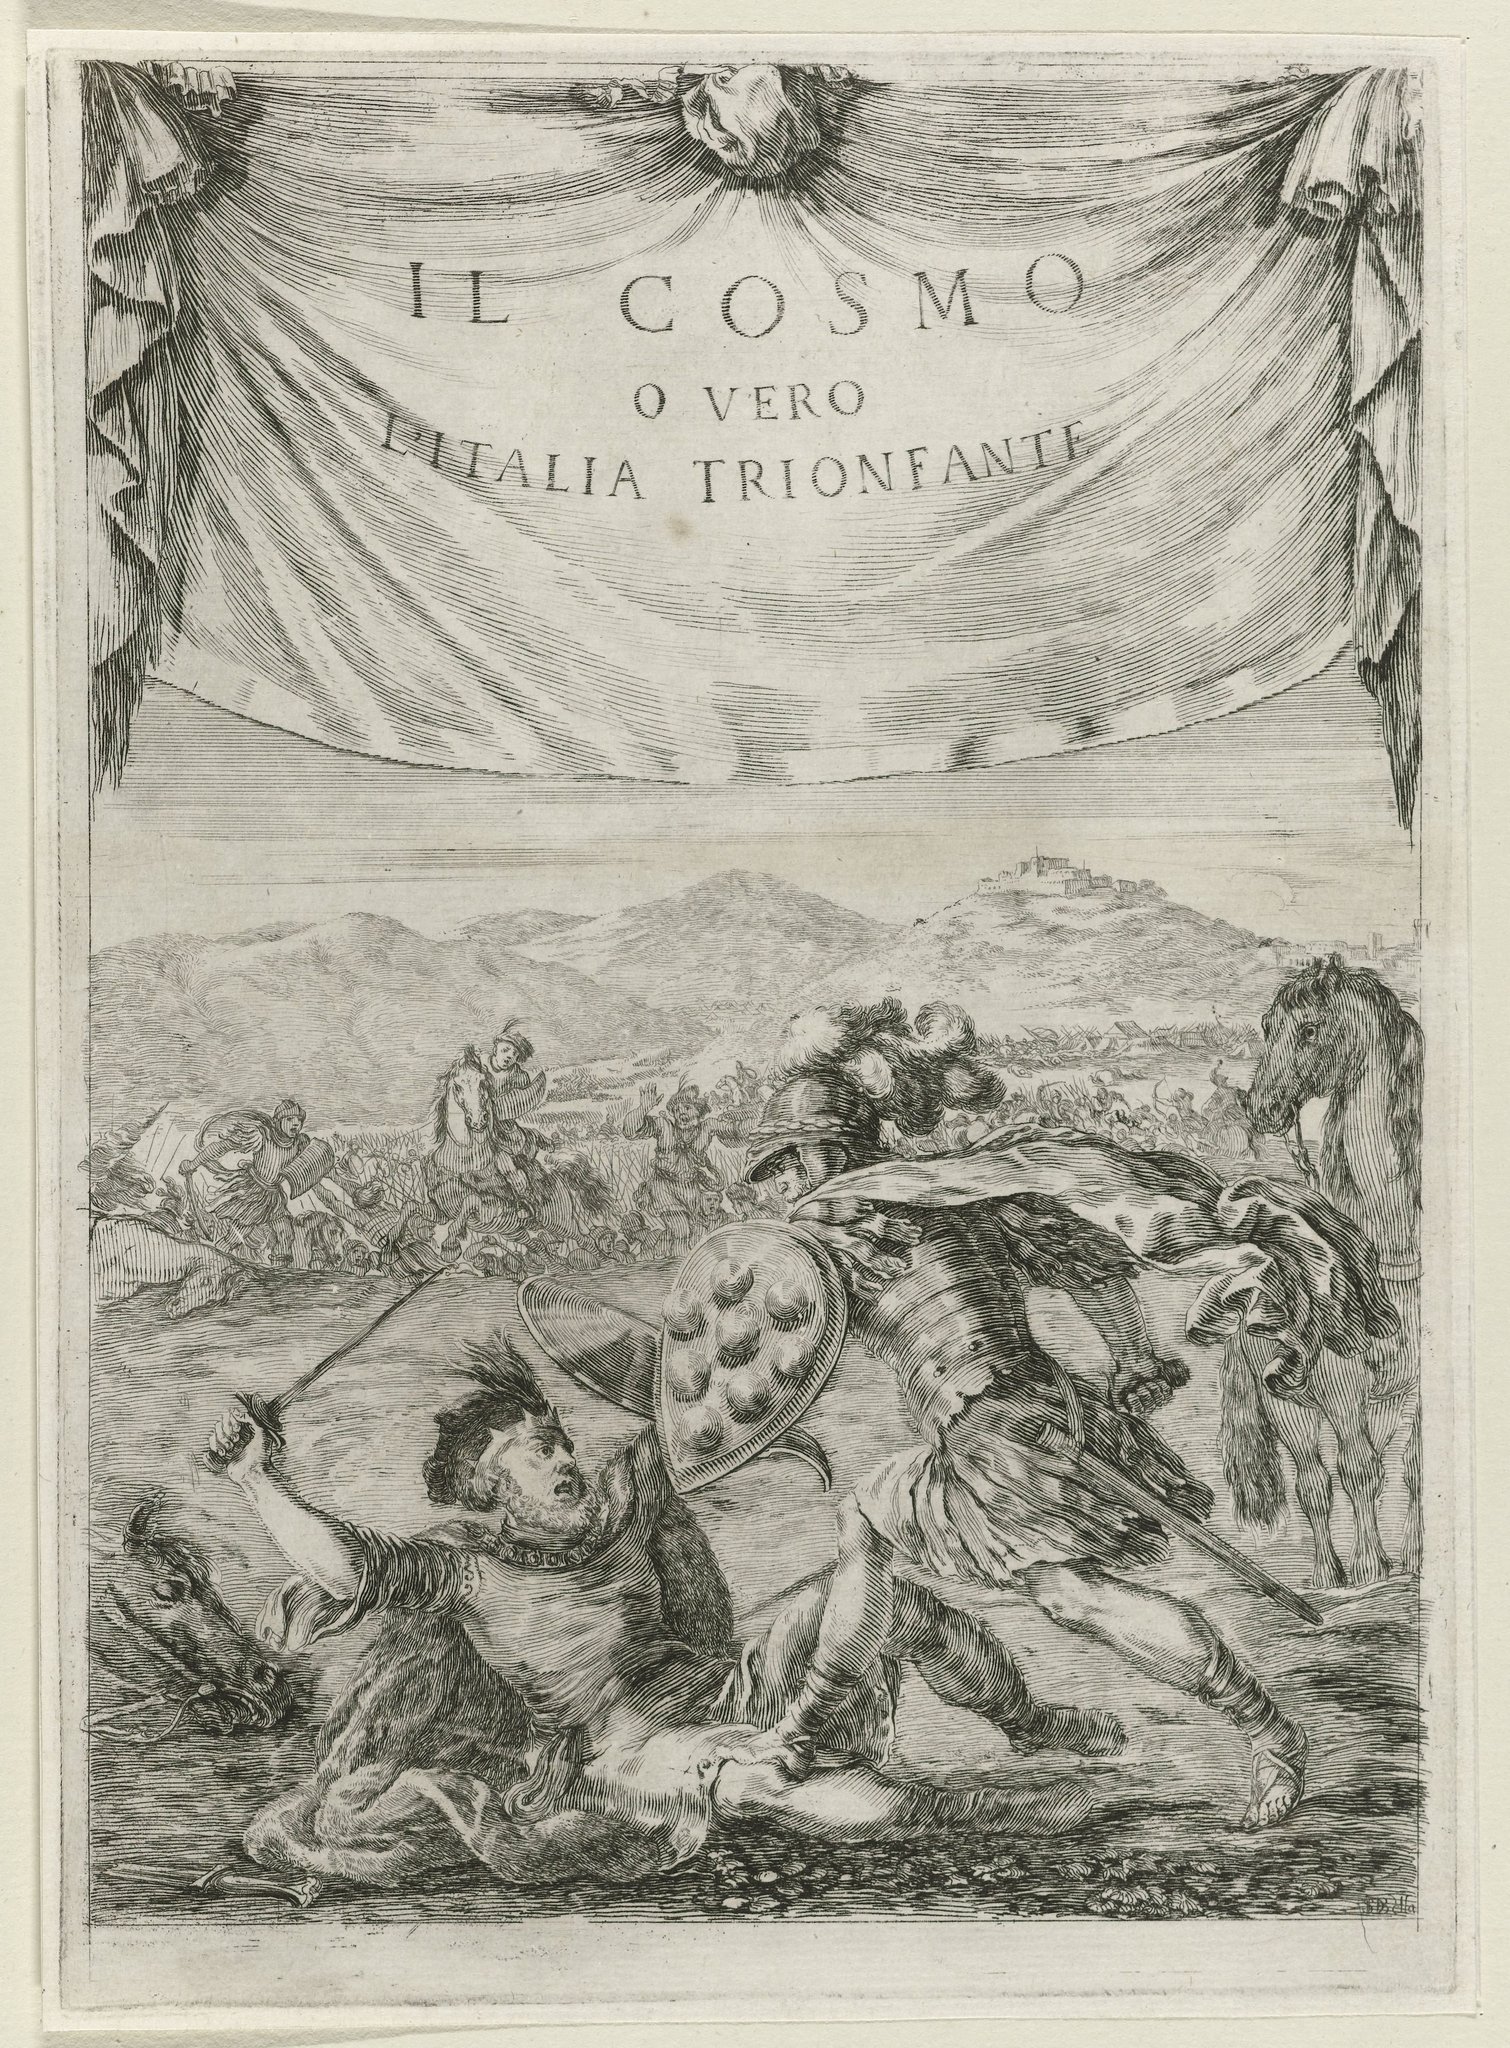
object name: print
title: Strijd tussen Cosmos en Radagario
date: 1650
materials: paper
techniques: etching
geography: florence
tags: battle, the soldier; the soldier's life, ruler, sovereign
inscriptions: collector's mark: Lugt 240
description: De soldaat Cosmos (Cosimo), met een schild met het wapen van de familie De'Medici, staat op het punt Radagario, koning van de Goten, te doden met zijn zwaard. Op de achtergrond het slagveld. Boven een draperie met titel.